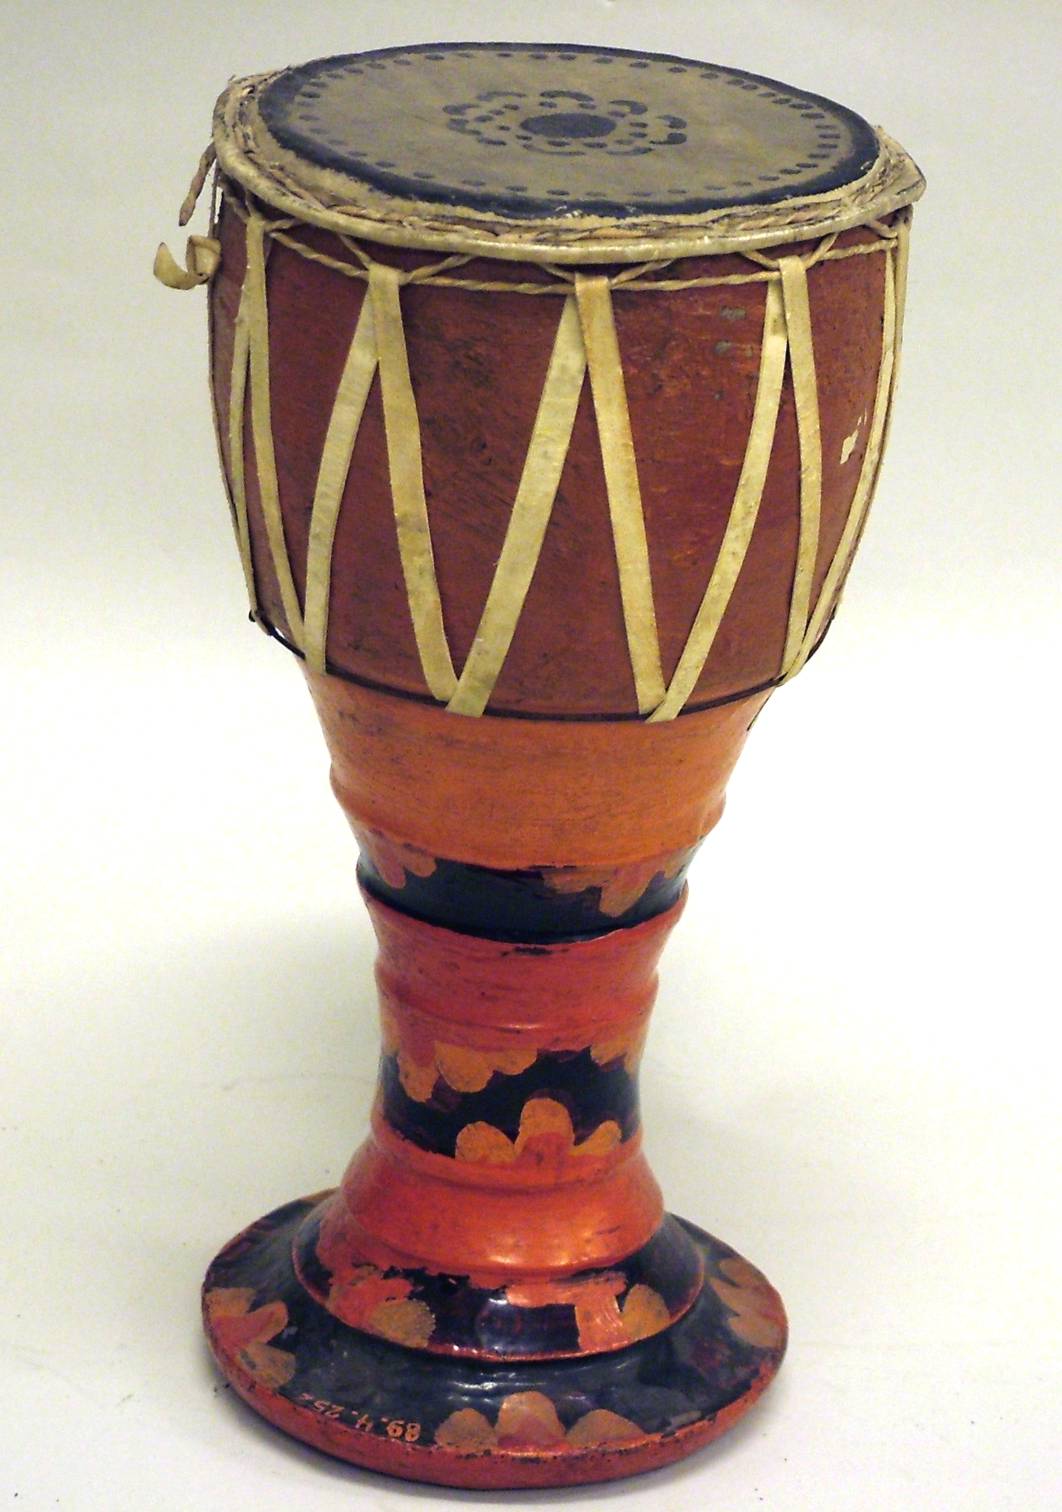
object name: ghutru or ozi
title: Ghutru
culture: burmese or indian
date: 1867-1900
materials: skin, metal, wood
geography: myanmar